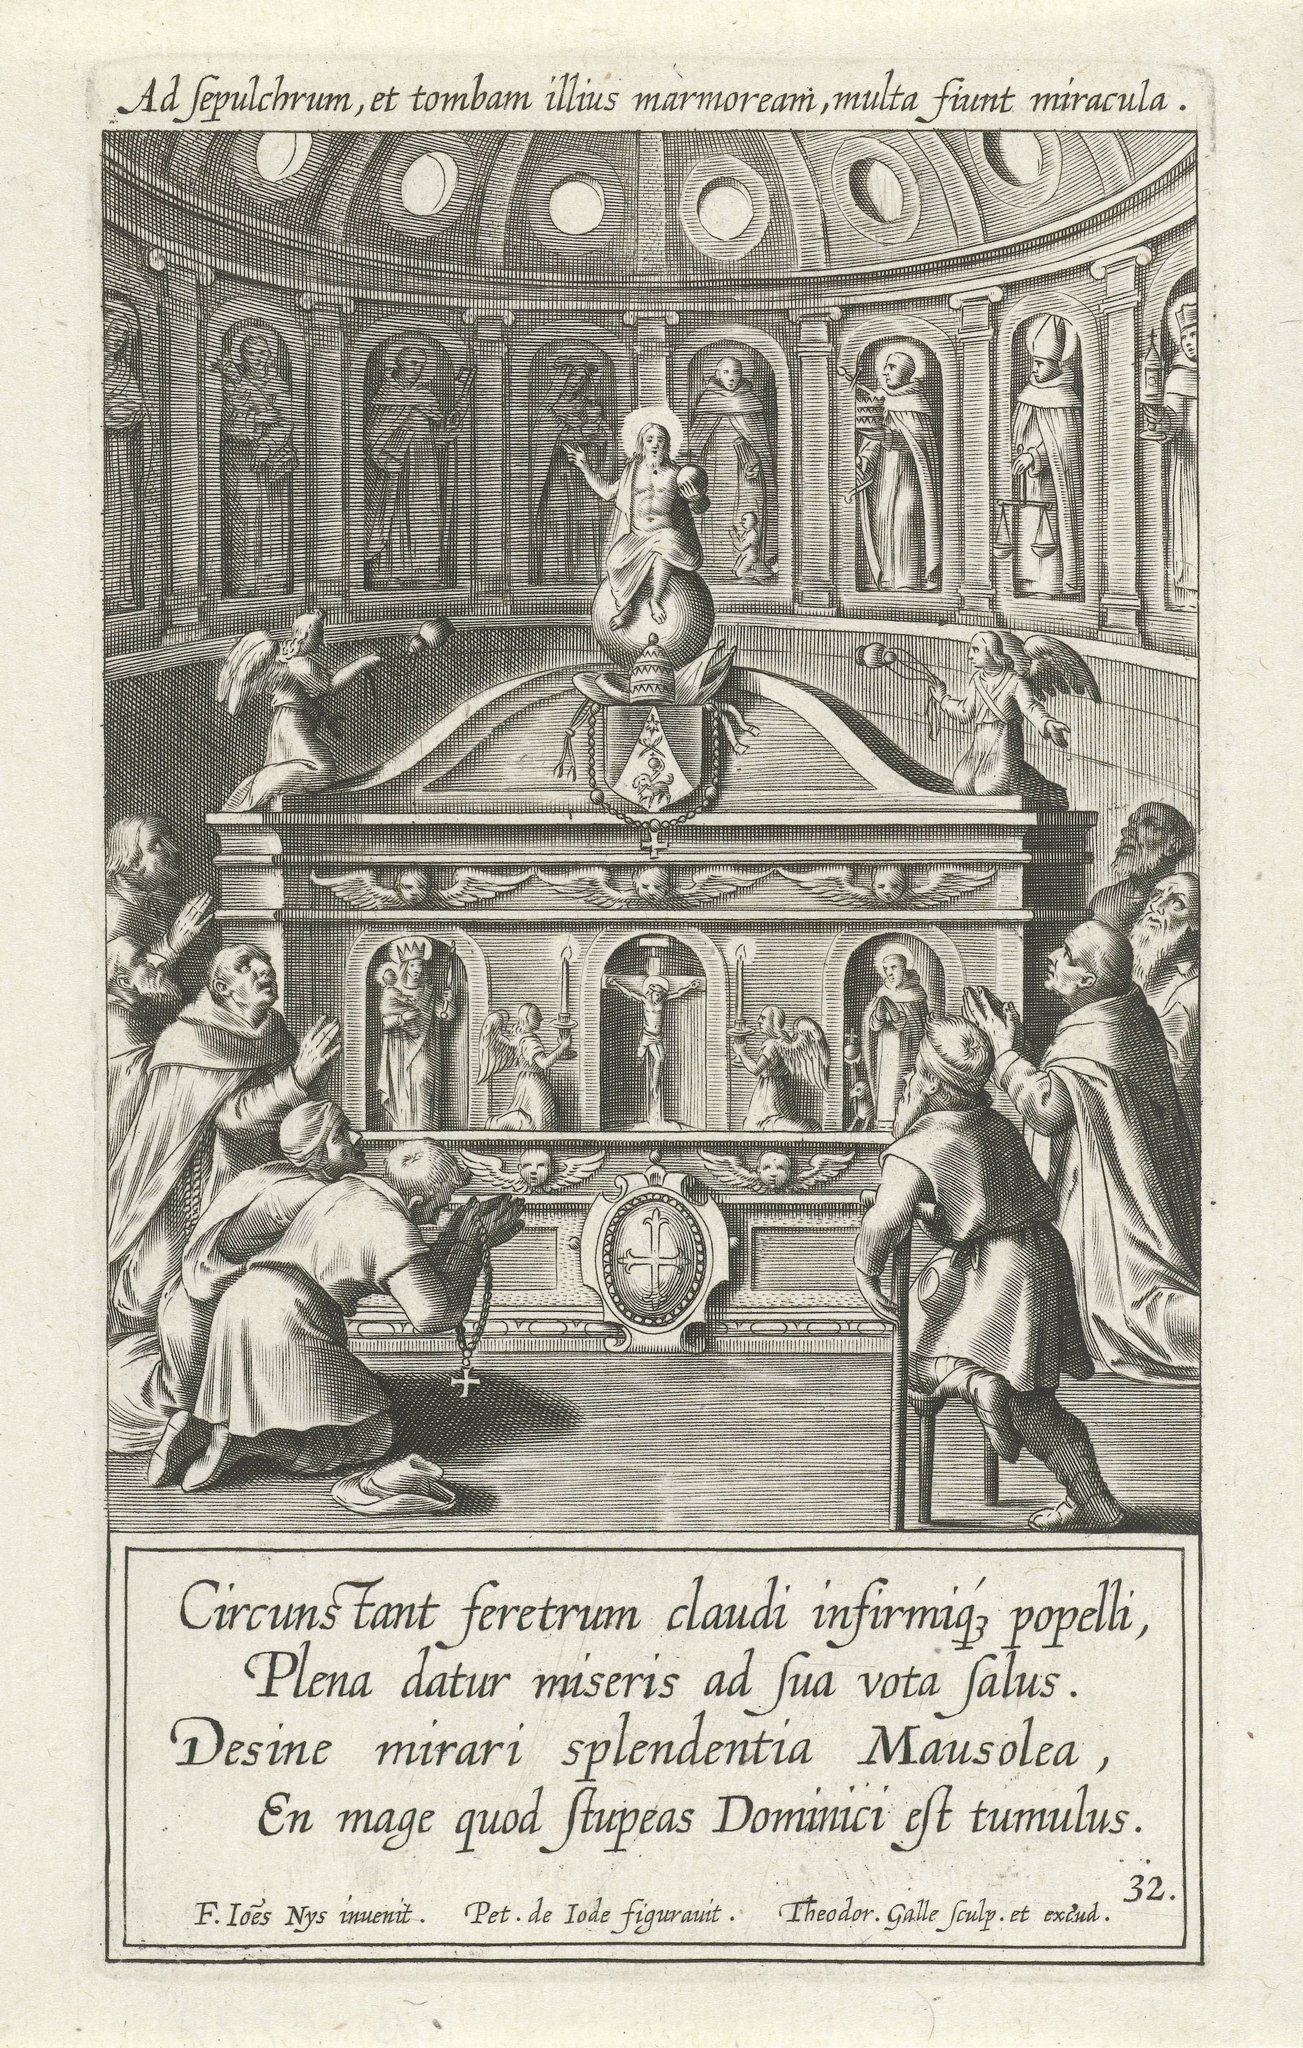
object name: print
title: Leven en mirakels van de heilige Dominicus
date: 1611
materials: paper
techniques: engraving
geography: antwerp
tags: dominic(us) guzman of calerueja, founder of the order of preachers (or dominican (black) friars; possible attributes: book, dog with flaming torch, lily, loaf of bread, rosary, star - beatification, canonization of male saint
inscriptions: collector's mark: Lugt 2228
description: De graftombe van de heilige Dominicus in Bologna. Mensen bidden bij zijn graf. De prent heeft een Latijns opschrift en onderschrift en maakt deel uit van een prentserie voor een boek over het leven van de heilige Dominicus.